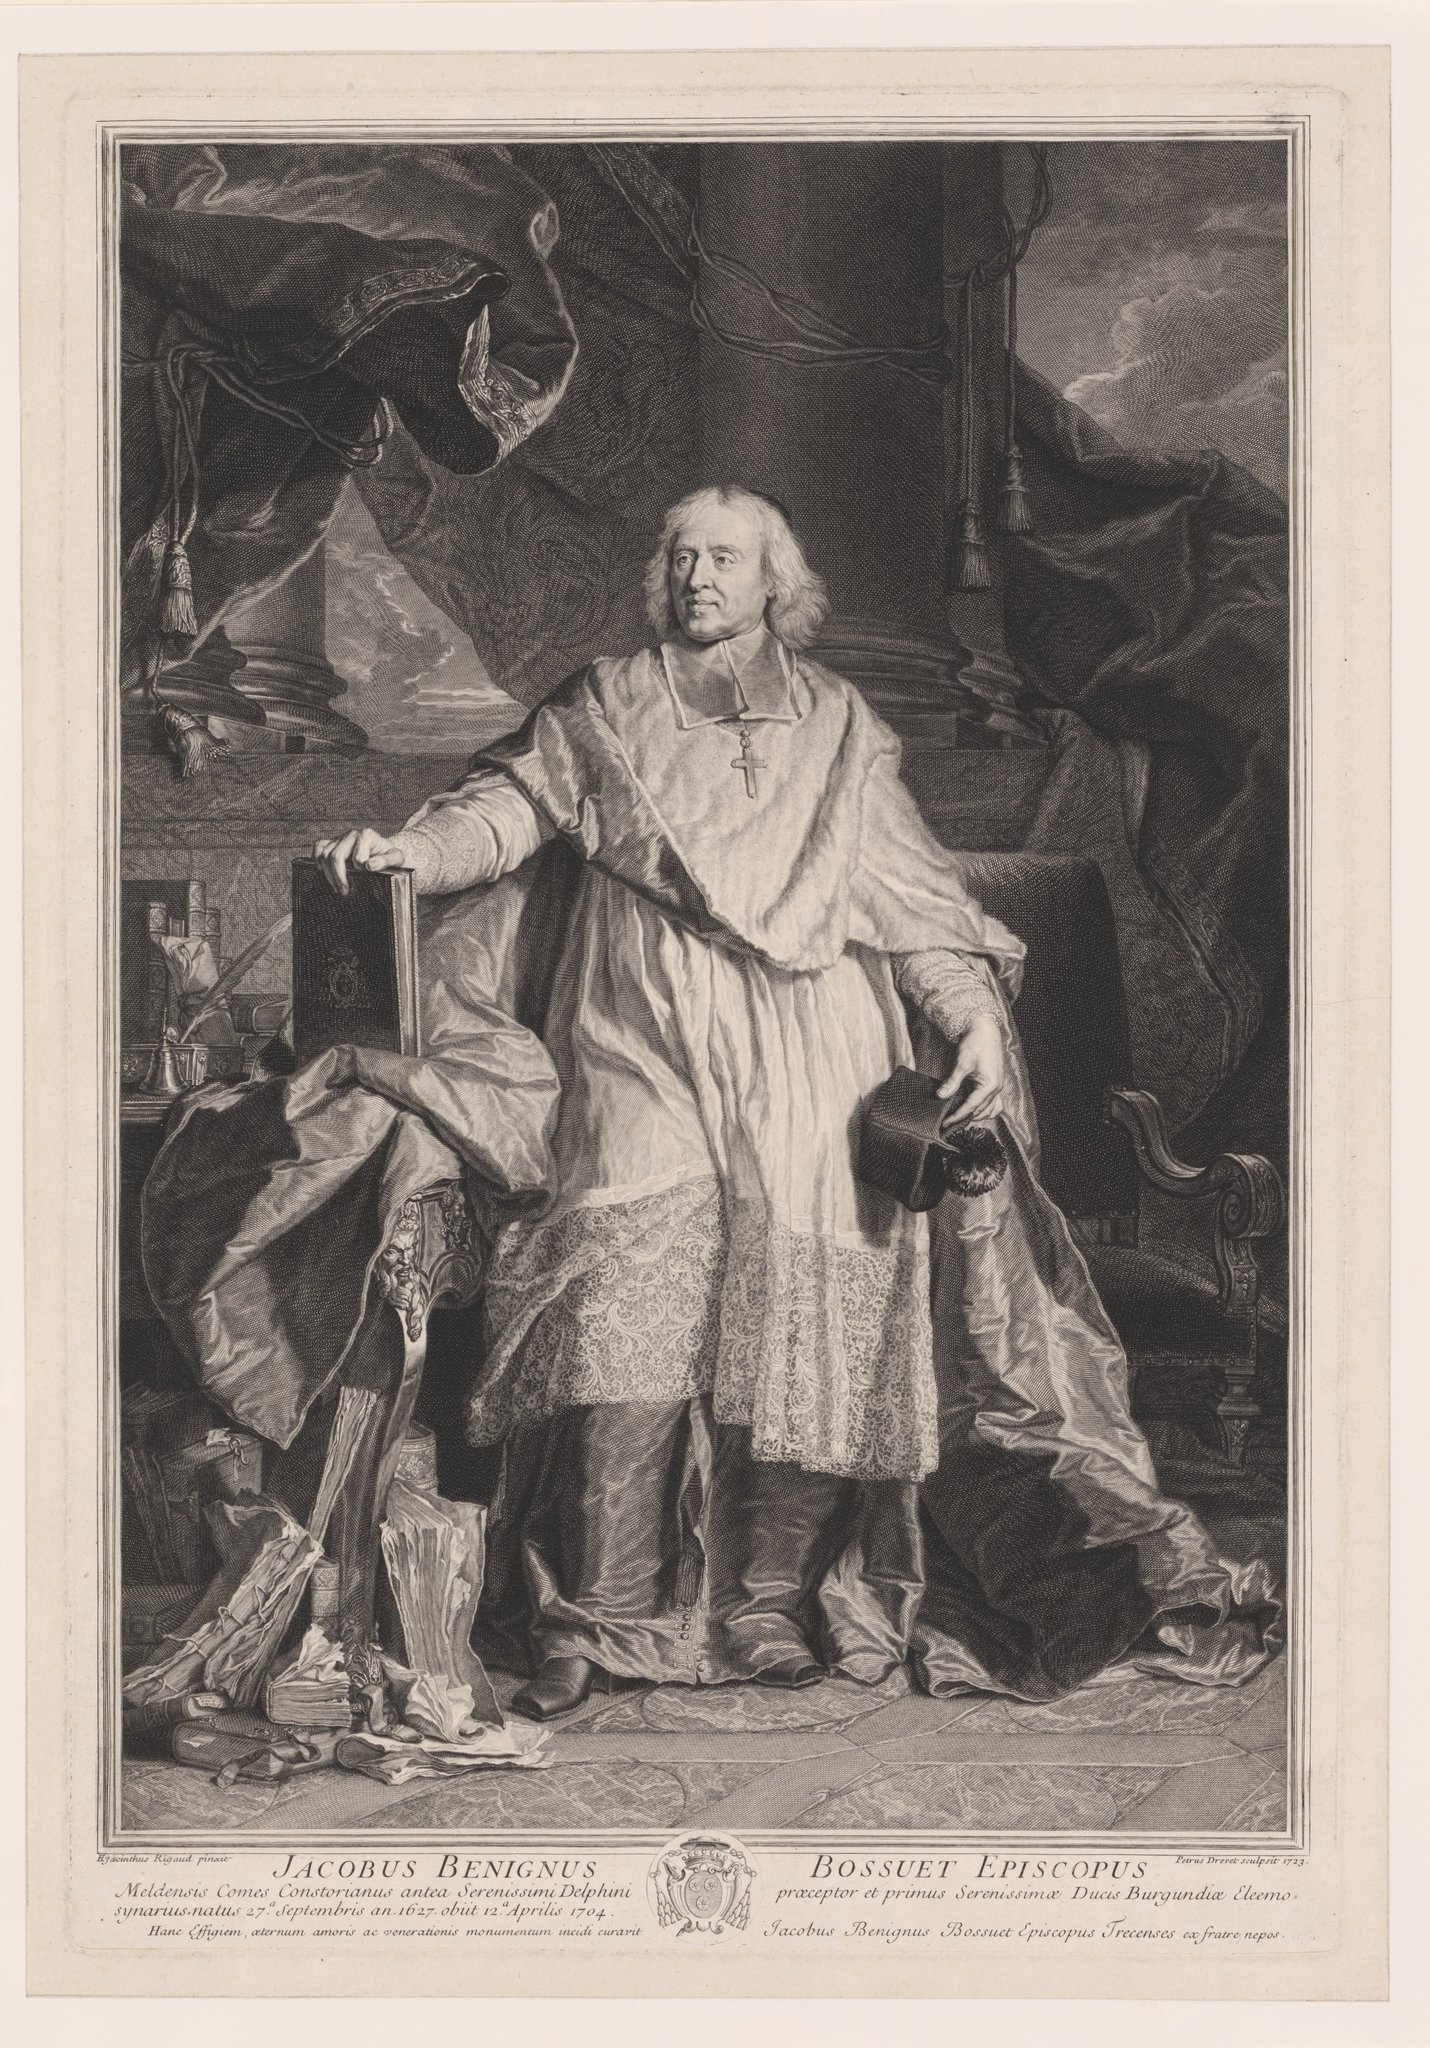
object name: print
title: Portret van Jacques-Bénigne Bossuet in zijn studeervertrek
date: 1723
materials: paper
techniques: engraving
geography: france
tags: scholar in his study, archbishop, bishop, etc. (roman catholic), historical persons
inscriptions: collector's mark: Lugt 240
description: Jacques-Bénigne Bossuet (1627-1704) was een veelzijdig man: bisschop, beroemd kanselier en polemist en een invloedrijk kerkelijk politicus onder Lodewijk XIV. Hyacinthe Rigaud schilderde in 1702 zijn portret als bisschop in vol ornaat. Het portret van Drevet, spiegelbeeldig aan het schilderij, wordt beschouwd als meesterwerk van de graveur, die in 1729 tot 'graveur du roi' werd benoemd.